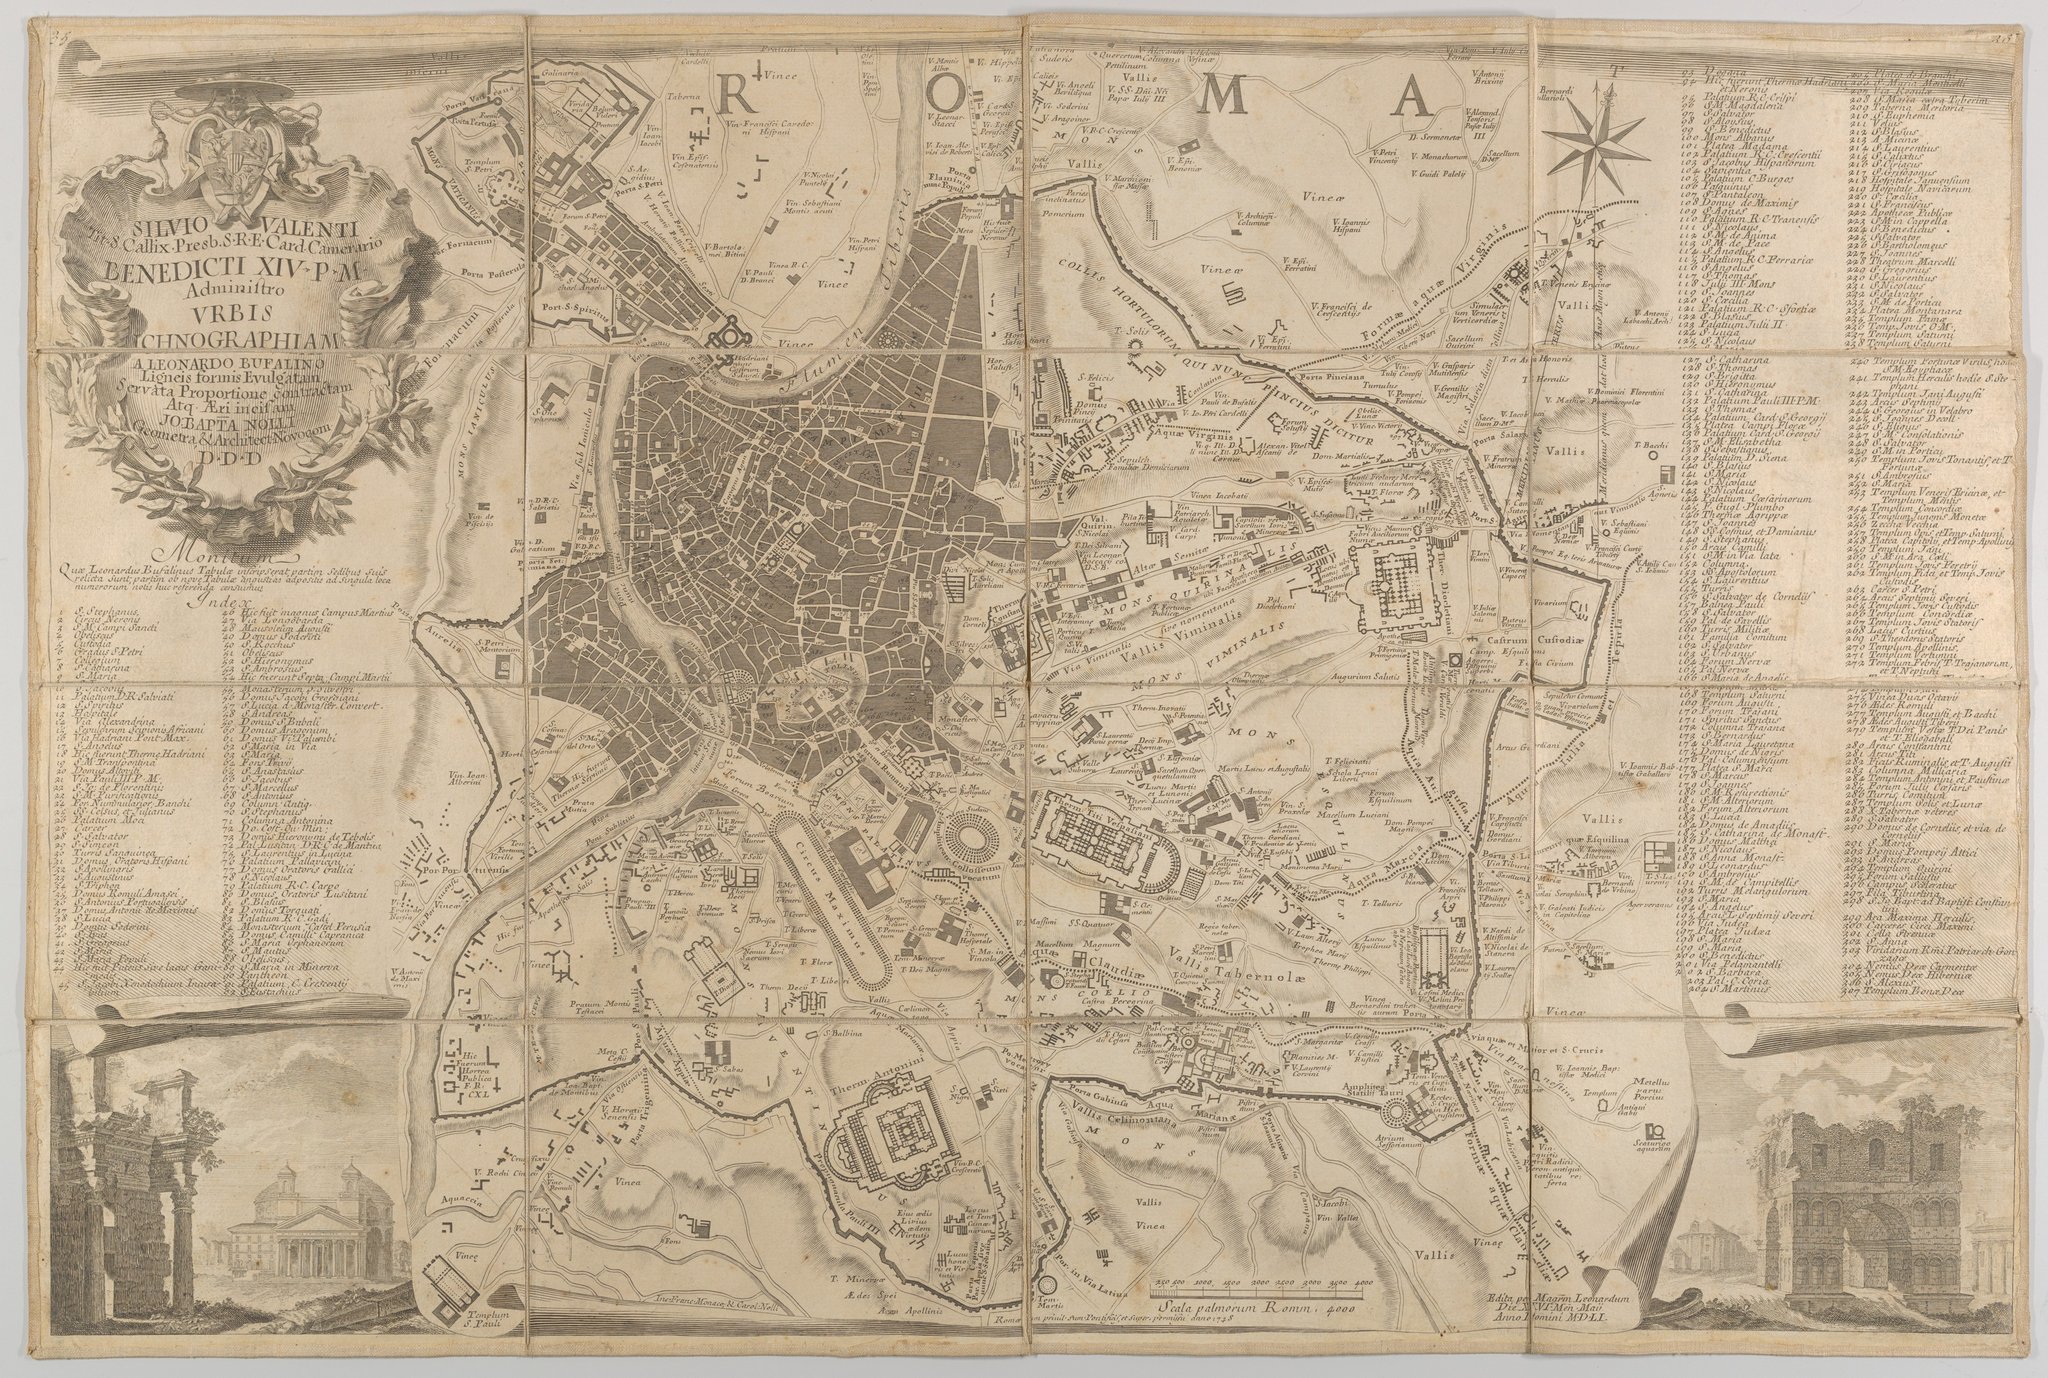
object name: book print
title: Plan of ancient Rome with a view of the Pantheon lower left and a triumphal arch lower right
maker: carlo nolli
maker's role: artist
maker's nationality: italian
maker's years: 1724-1775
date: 1748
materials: linen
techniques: backing, etching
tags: cities,maps